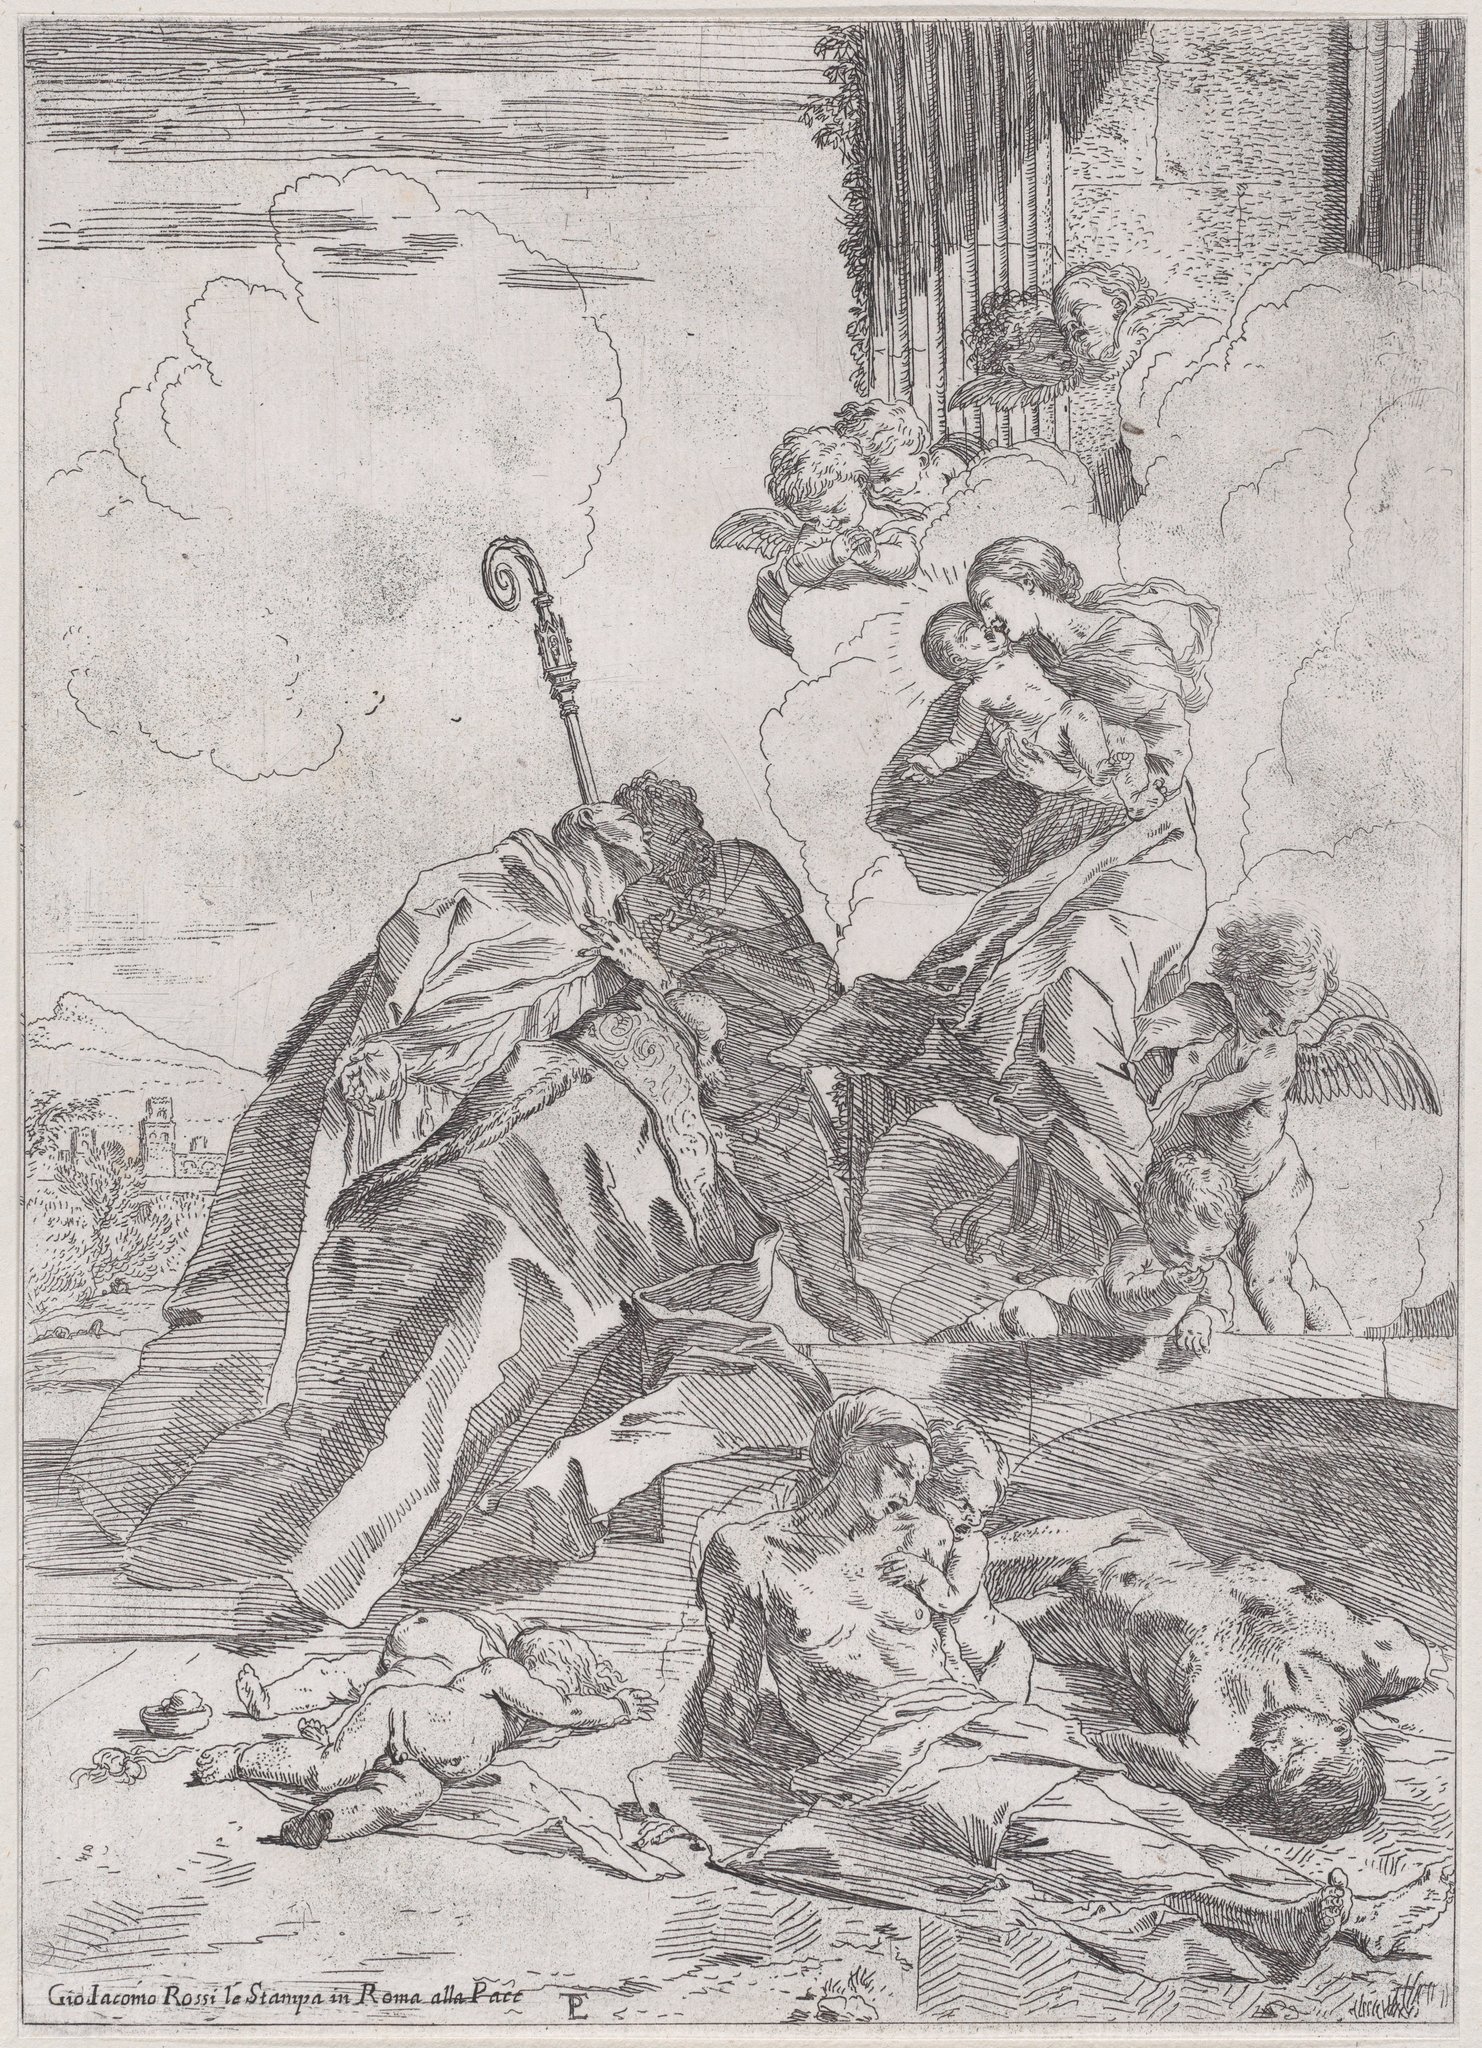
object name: print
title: Three Luchese saints Sts Nicholas Tolentino, Nicholas of Bari interceding with the Virgin for the victims of the plague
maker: pietro testa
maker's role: artist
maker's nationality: italian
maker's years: 1612-1650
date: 1630-1631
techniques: etching